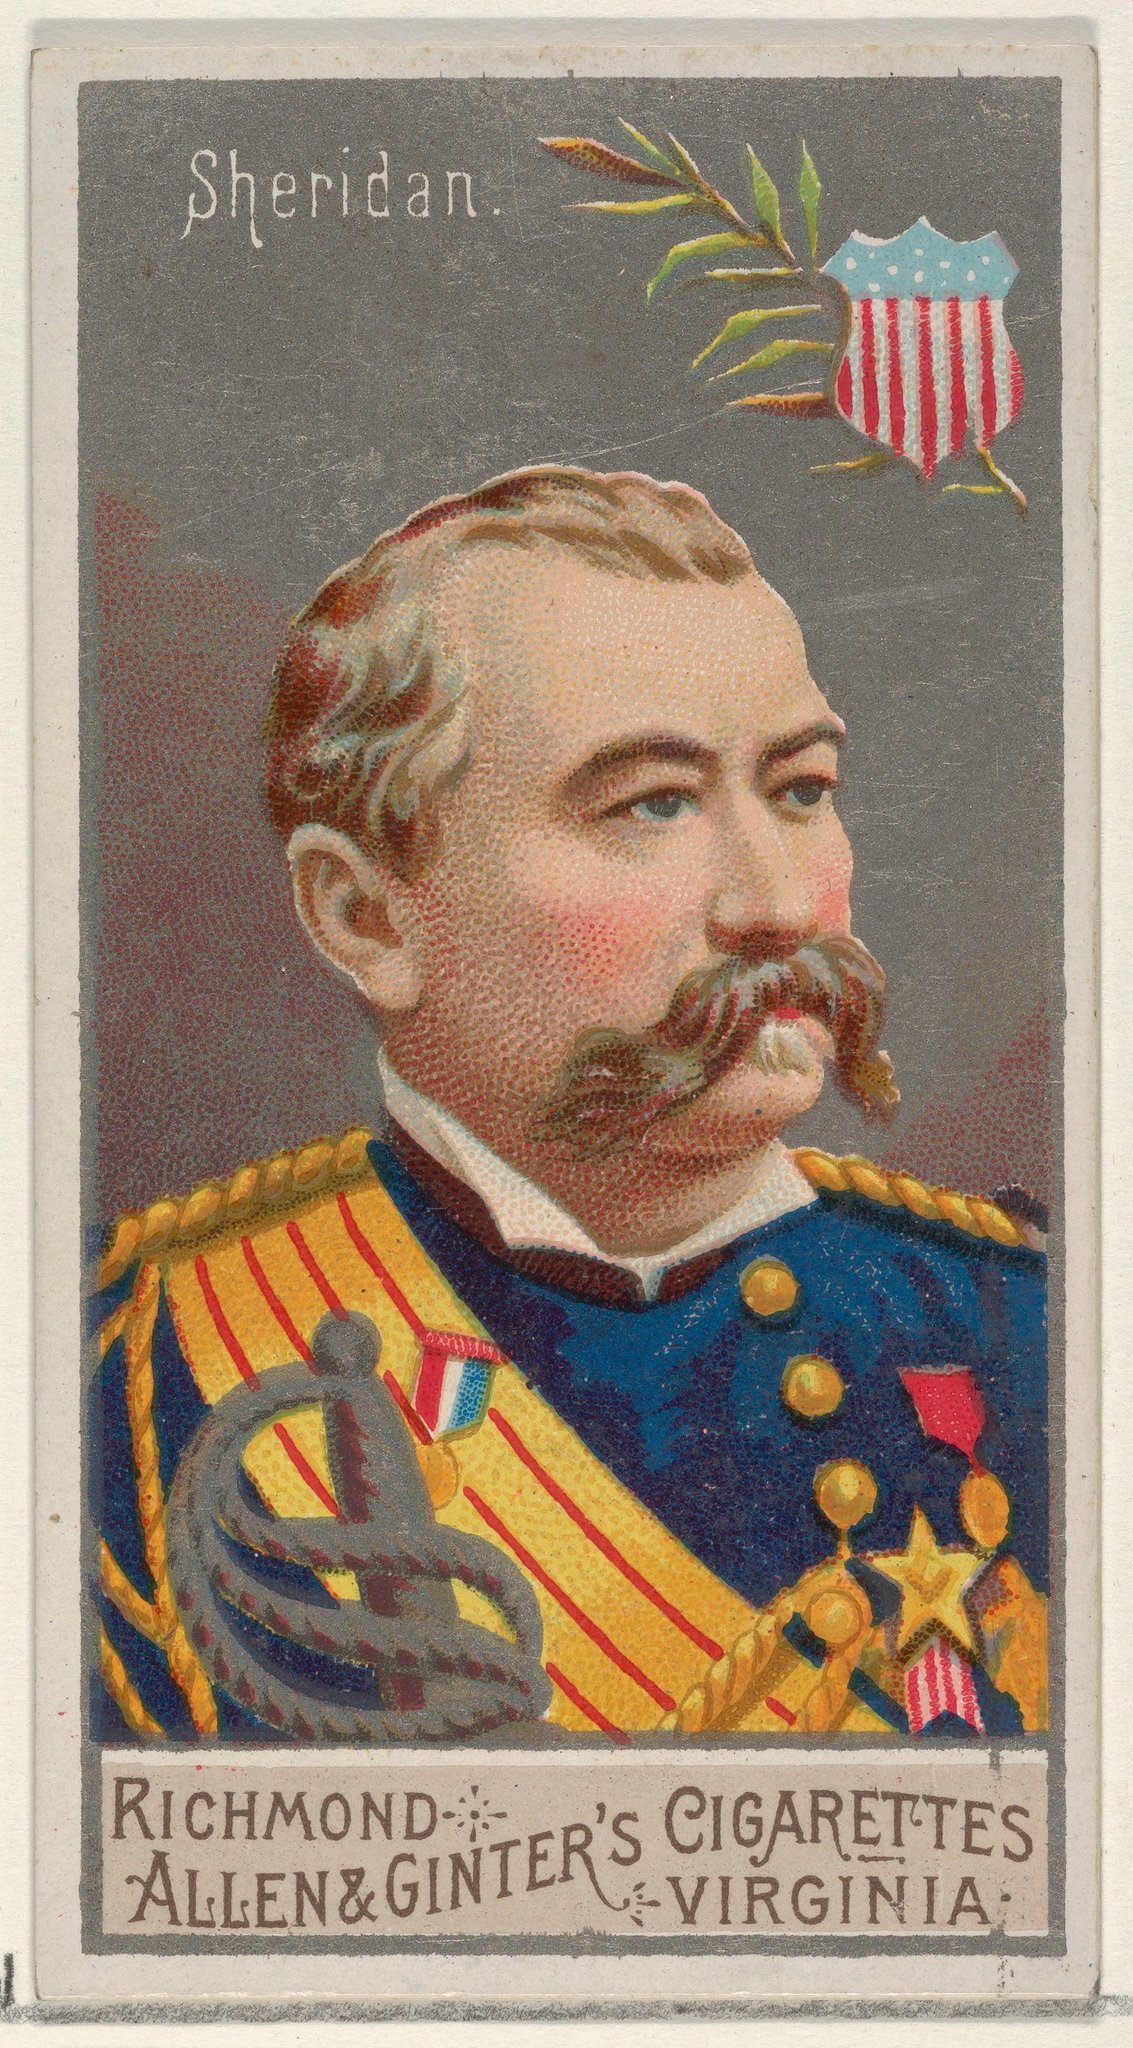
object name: print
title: Philip Henry Sheridan, from the Great Generals series (N15) for Allen & Ginter Cigarettes Brands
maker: allen & ginter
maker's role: publisher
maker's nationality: american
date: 1888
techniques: color lithograph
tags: men,generals